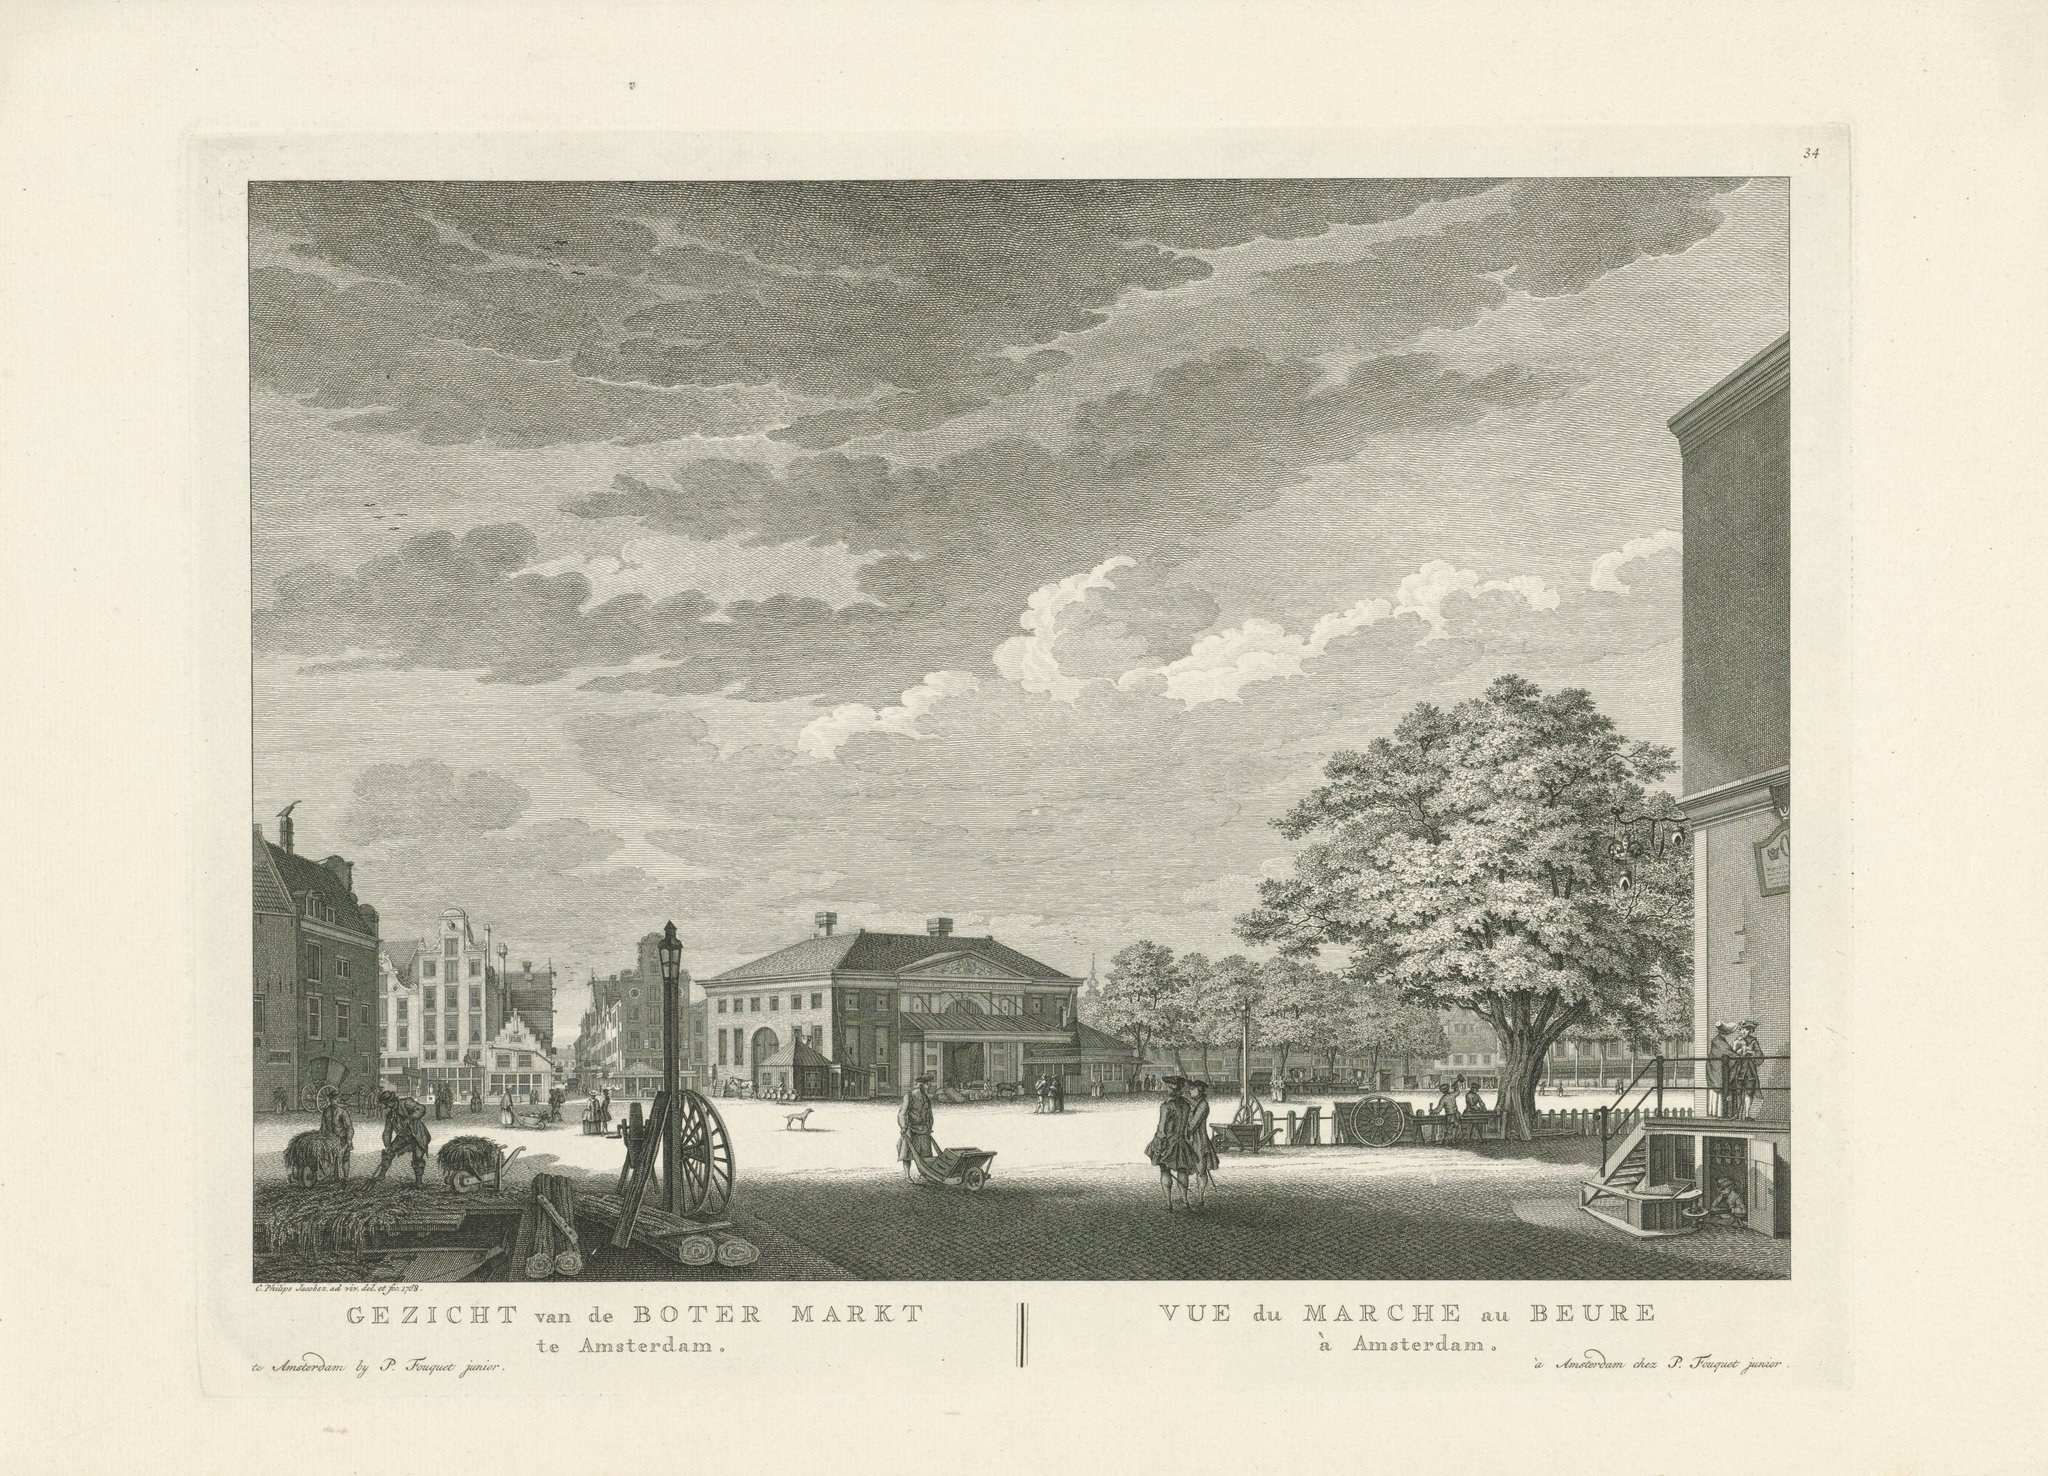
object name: print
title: Gezicht van de Boter Markt te Amsterdam / Vue du Marche au Beure à Amsterdam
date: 1768-1783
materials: paper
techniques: engraving, etching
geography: amsterdam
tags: weigh-house, square, place, circus, etc. (+ city(-scape) with figures, staffage)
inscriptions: collector's mark: Lugt 2228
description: Deze prent is ook gebruikt in de zogenaamde Atlas van Fouquet.* Pierre Fouquet gaf vanaf 1760 stadsgezichten van Amsterdam - naar tekeningen van verschillende kunstenaars, gemaakt door verschillende prentmakers - uit. Deze prenten werden aanvankelijk los of in series verkocht. Zoals toen gebruikelijk kon de koper de prenten zelf laten inbinden. Hiertoe gaf Fouquet tussen 1778 en 1783 een titelblad, plattegrond en inhoudsopgave van de tot dusver 100 uitgegeven prenten uit (1). Gezien de inhoud afhankelijk was van wat de koper had verzameld verschilt de inhoud van de verschillende bewaarde Fouquetatlassen onder deze titel sterk. Ook zijn er exemplaren bekend waar tevens andere prenten aan zijn toegevoegd. Omdat er behoefte bleek aan uitleg bij de platen werd in 1783 een nieuwe versie van de atlas uitgegeven, aangevuld met tekst en twee prenten. De aangegeven volgorde veranderde maar de platen van de al eerder uitgegeven prenten bleven ongewijzigd. Deze uitgave werd in opdracht van Fouquet gedrukt bij Daniël Jean Changuion en Petrus den Hengst (2). Een tiental platen werd bijgewerkt en verscheen, met nieuw impressum, in het vervolg van Wagenaars geschiedenis van Amsterdam, uitgeven door Petrus Conradi en Folkert van der Plaats (3). Een aantal jaar na het overlijden van Fouquet kwam Evert Maaskamp met een nieuwe uitgave van de atlas, met verbeterde tekst en toevoeging van twee prenten. Op alle platen verwijderde hij het oude en liet hij zijn eigen impressum zetten (4). De huidige staat van de prent komt voor in exemplaren van de onder (1) en (2) genoemde werken. * Onder de Atlas van Fouquet of Fouquetatlas verstaan we de hieronder vermelde publicaties (1), (2) en (4). (1). Afbeeldingen van de wyd-vermaarde koopstad Amsterdam benevens des zelvs voornaamste gebouwen en gezigten alle naar het leeven getekend / Receuil des edifices les plus considerables et des plus belles vues, de la fameuse ville d'Amsterdam, dessinées d'après nature. Amsterdam: Pierre Fouquet, 1778-1783. (2). Nieuwe atlas, van de voornaamste gebouwen en gezigten der stad Amsterdam, met derzelver beknopte beschryvingen. 2 delen. Amsterdam: Daniël Jean Changuion en Petrus den Hengst [in opdracht van Pierre Fouquet], 1783. (3). Stijl, Simon. Amsterdam, in zyne geschiedenissen, voorregten, koophandel, gebouwen, kerkenstaat, schoolen, schutterye, gilden en regeeringe, beschreeven. Om te dienen ten vervolge op het werk van Jan Wagenaar (…). 10 delen. Amsterdam en Harlingen: Petrus Conradi en Folkert van der Plaats, 1788-1801. (4). Nieuwe atlas, van de voornaamste gebouwen en gezigten der stad Amsterdam. Met derzelver beknopte beschryvingen. Amsterdam: Evert Maaskamp, 1805. * Het aantal vermelde staten is gebaseerd op het aantal gevonden staten. Mogelijk zijn er meer staten van deze prent.